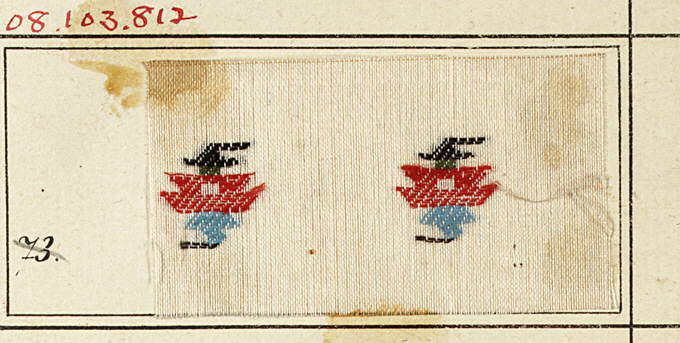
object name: ribbon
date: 1701-1900